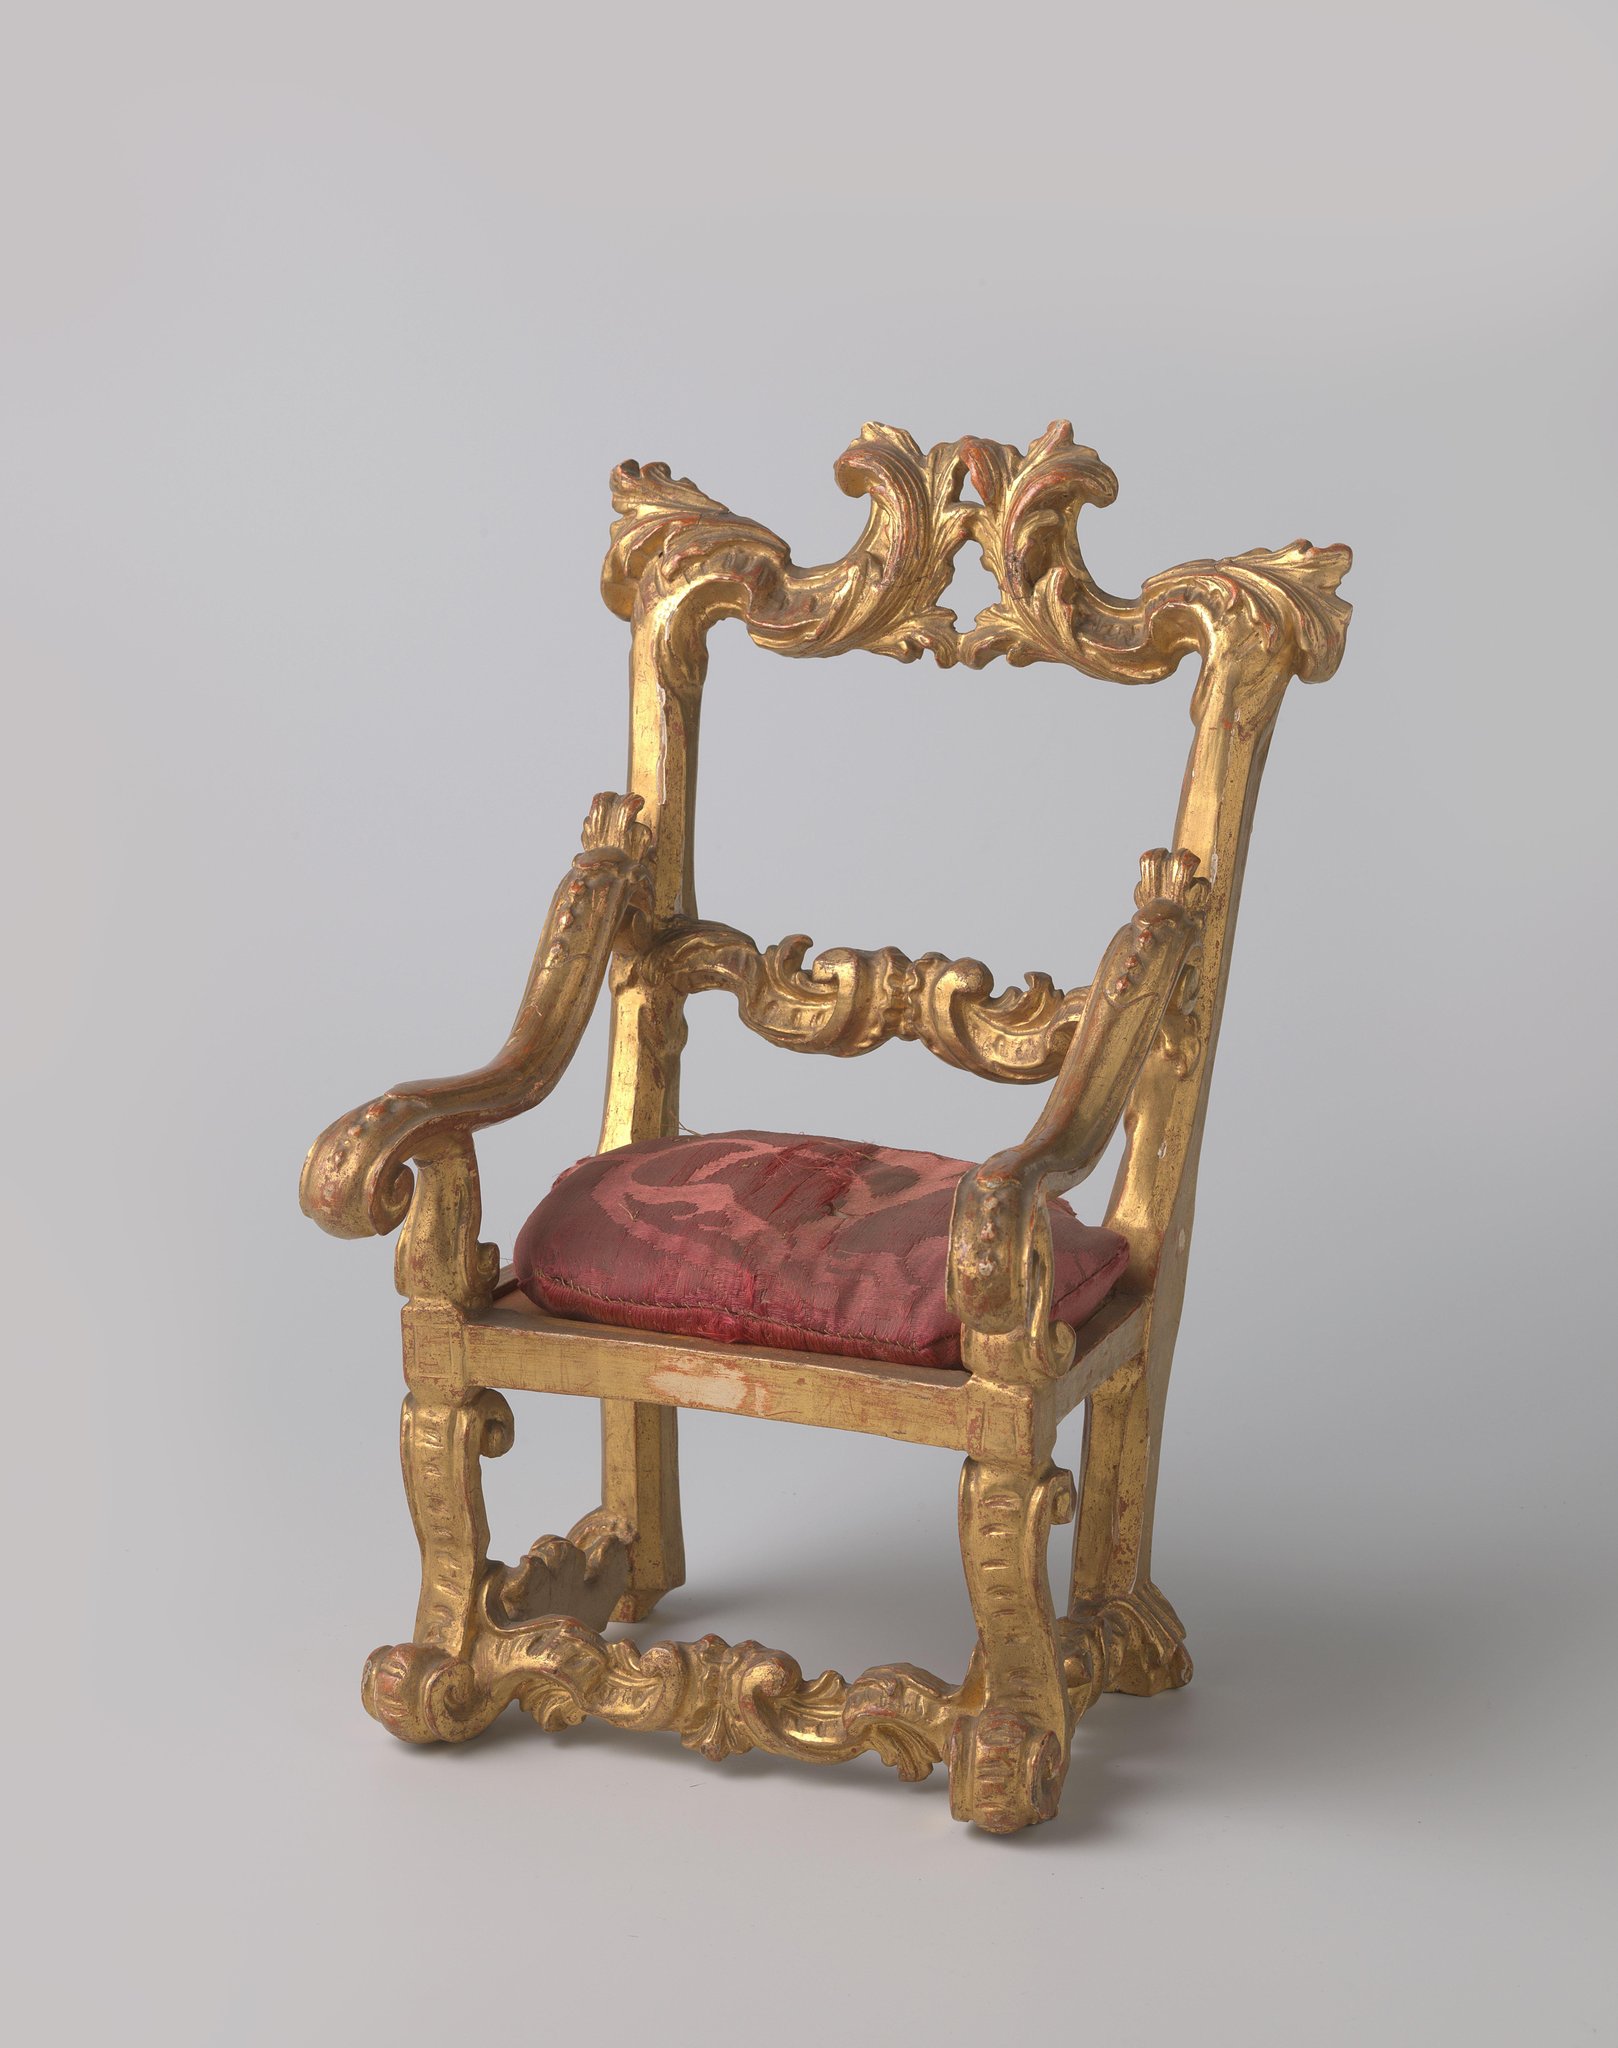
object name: toy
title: Meubilair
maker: Anonymous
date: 1600-1750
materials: wood, textile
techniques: gilding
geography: italy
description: Verguld gesneden armstoel, bestaande uit Louis-XIV-krullen en acanthusvoluten. De rug heeft één sport en een rijk gesneden bovendorpel met bladvoluten. De diep geholde armleggers vertonen kloksnoeren. Rood satijnen kussen. Kinderspeelgoed.